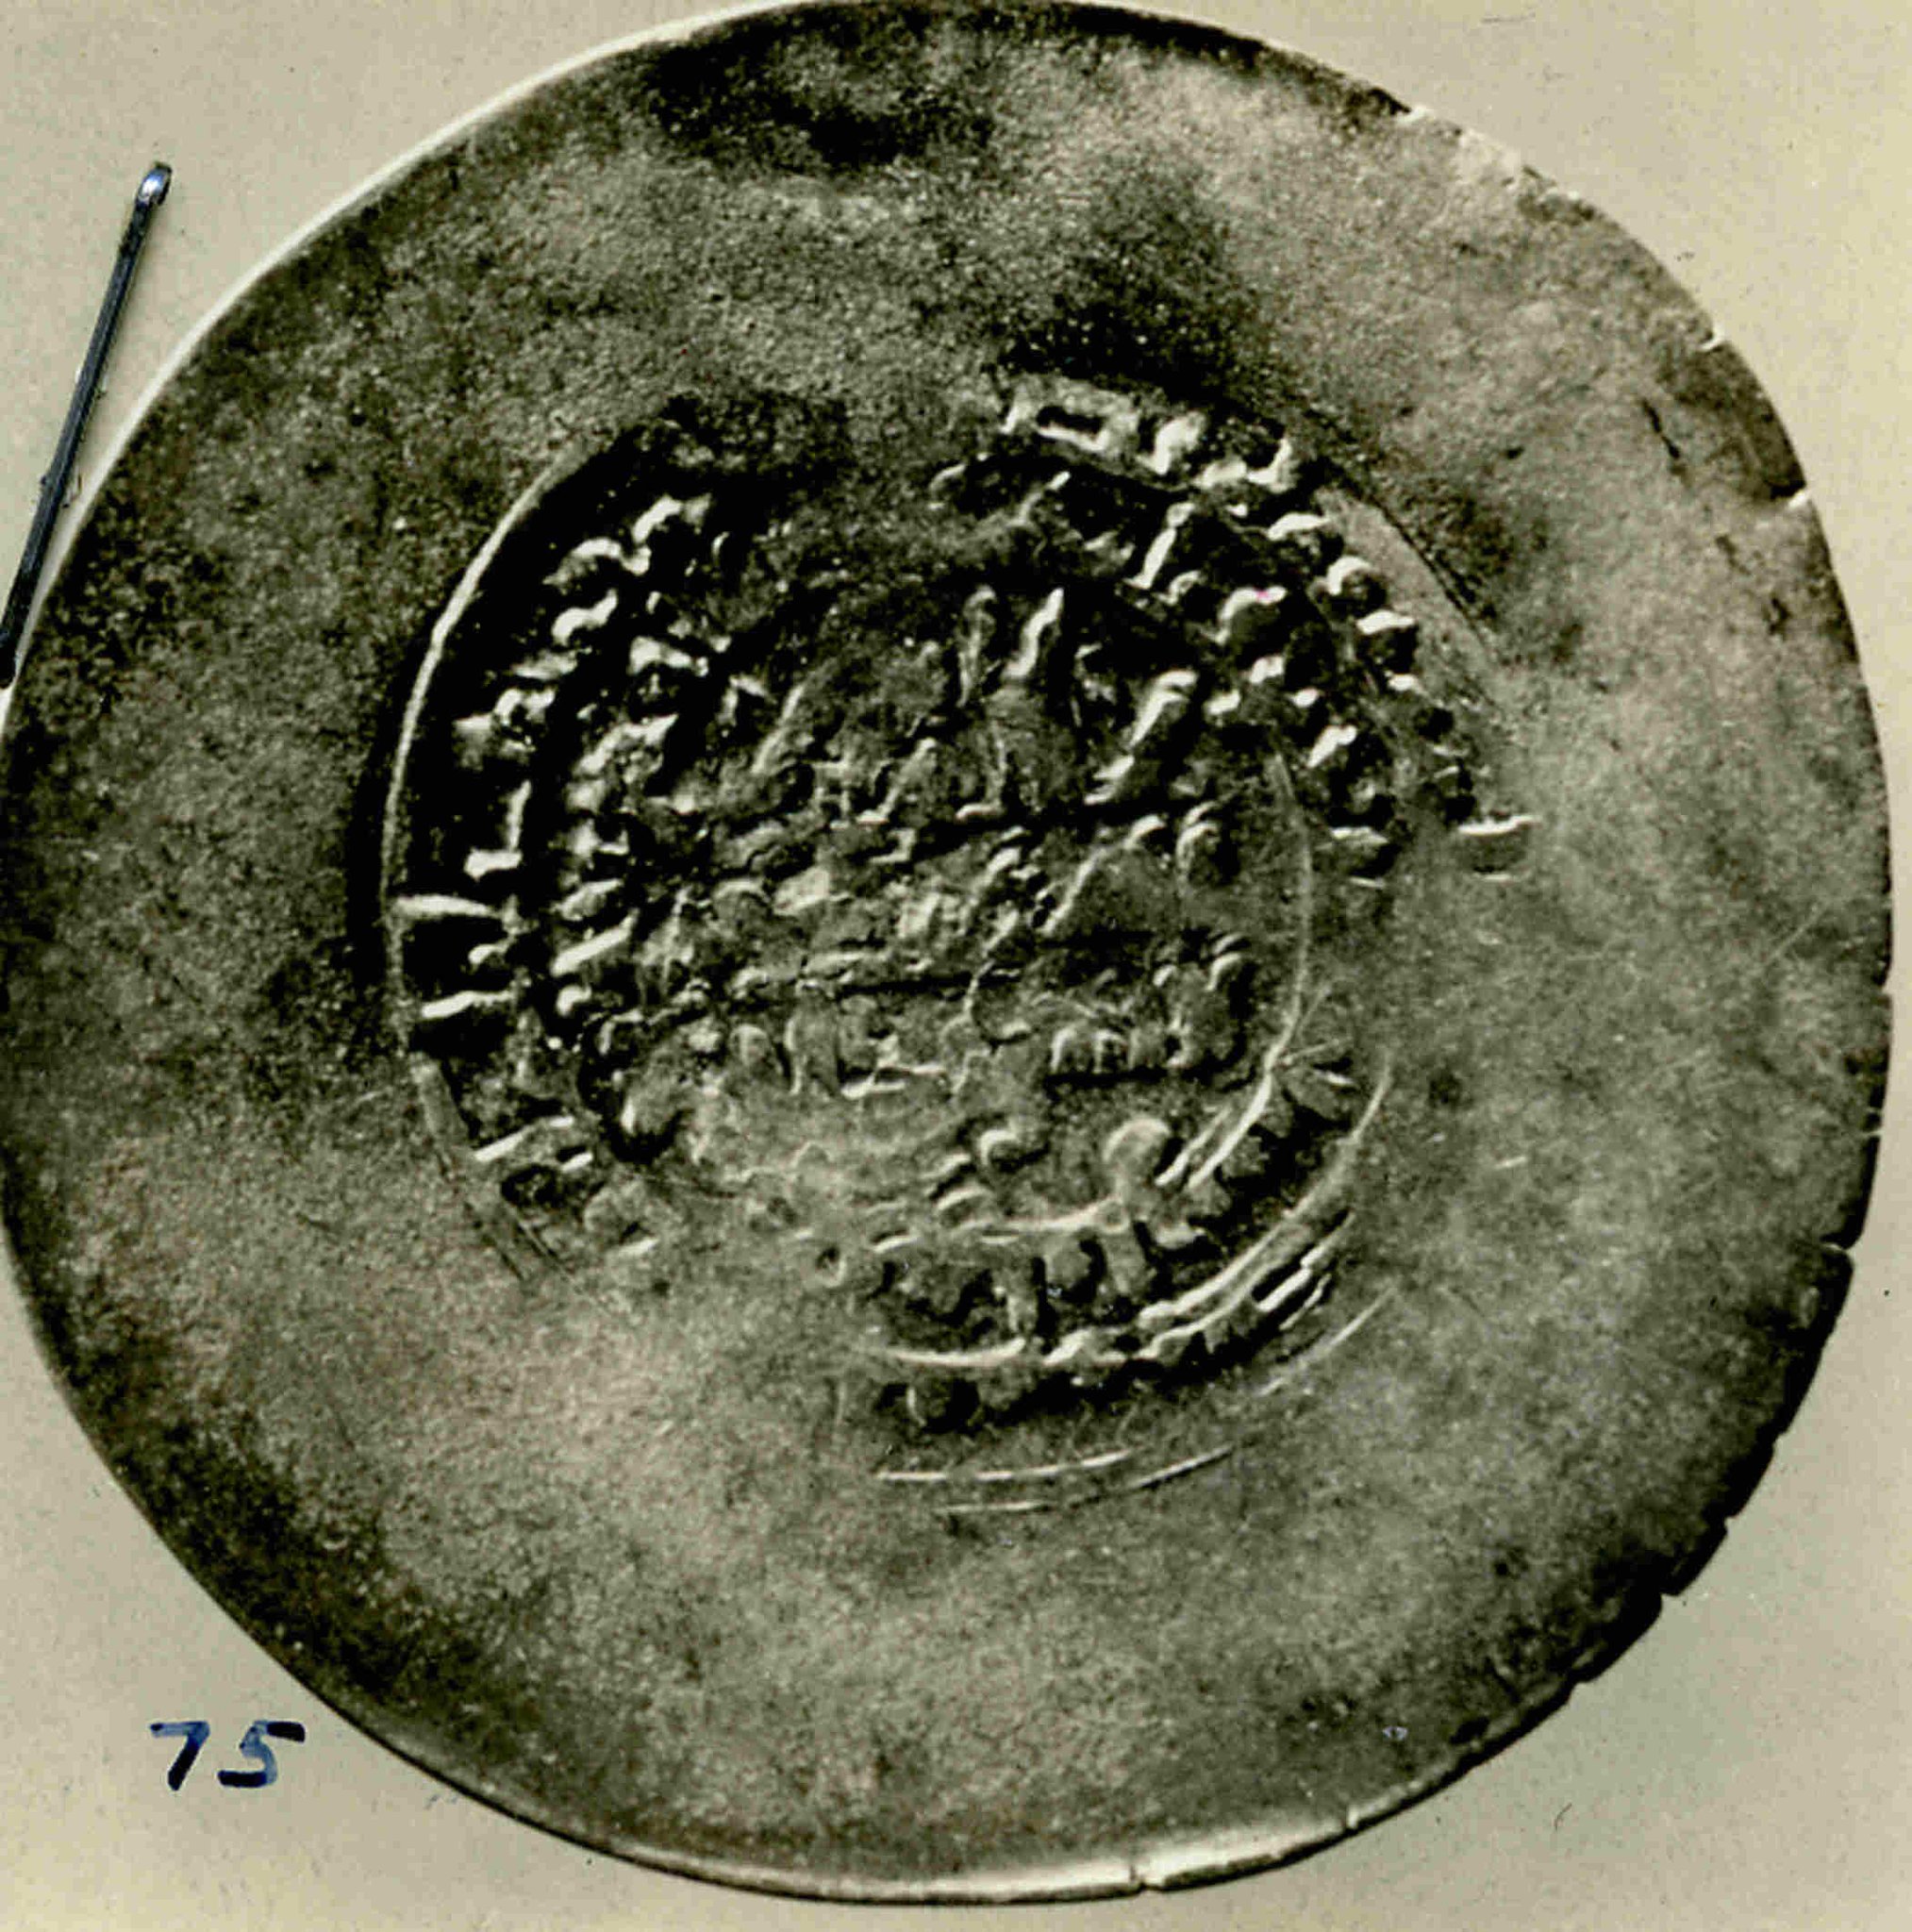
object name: coin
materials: silver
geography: iran